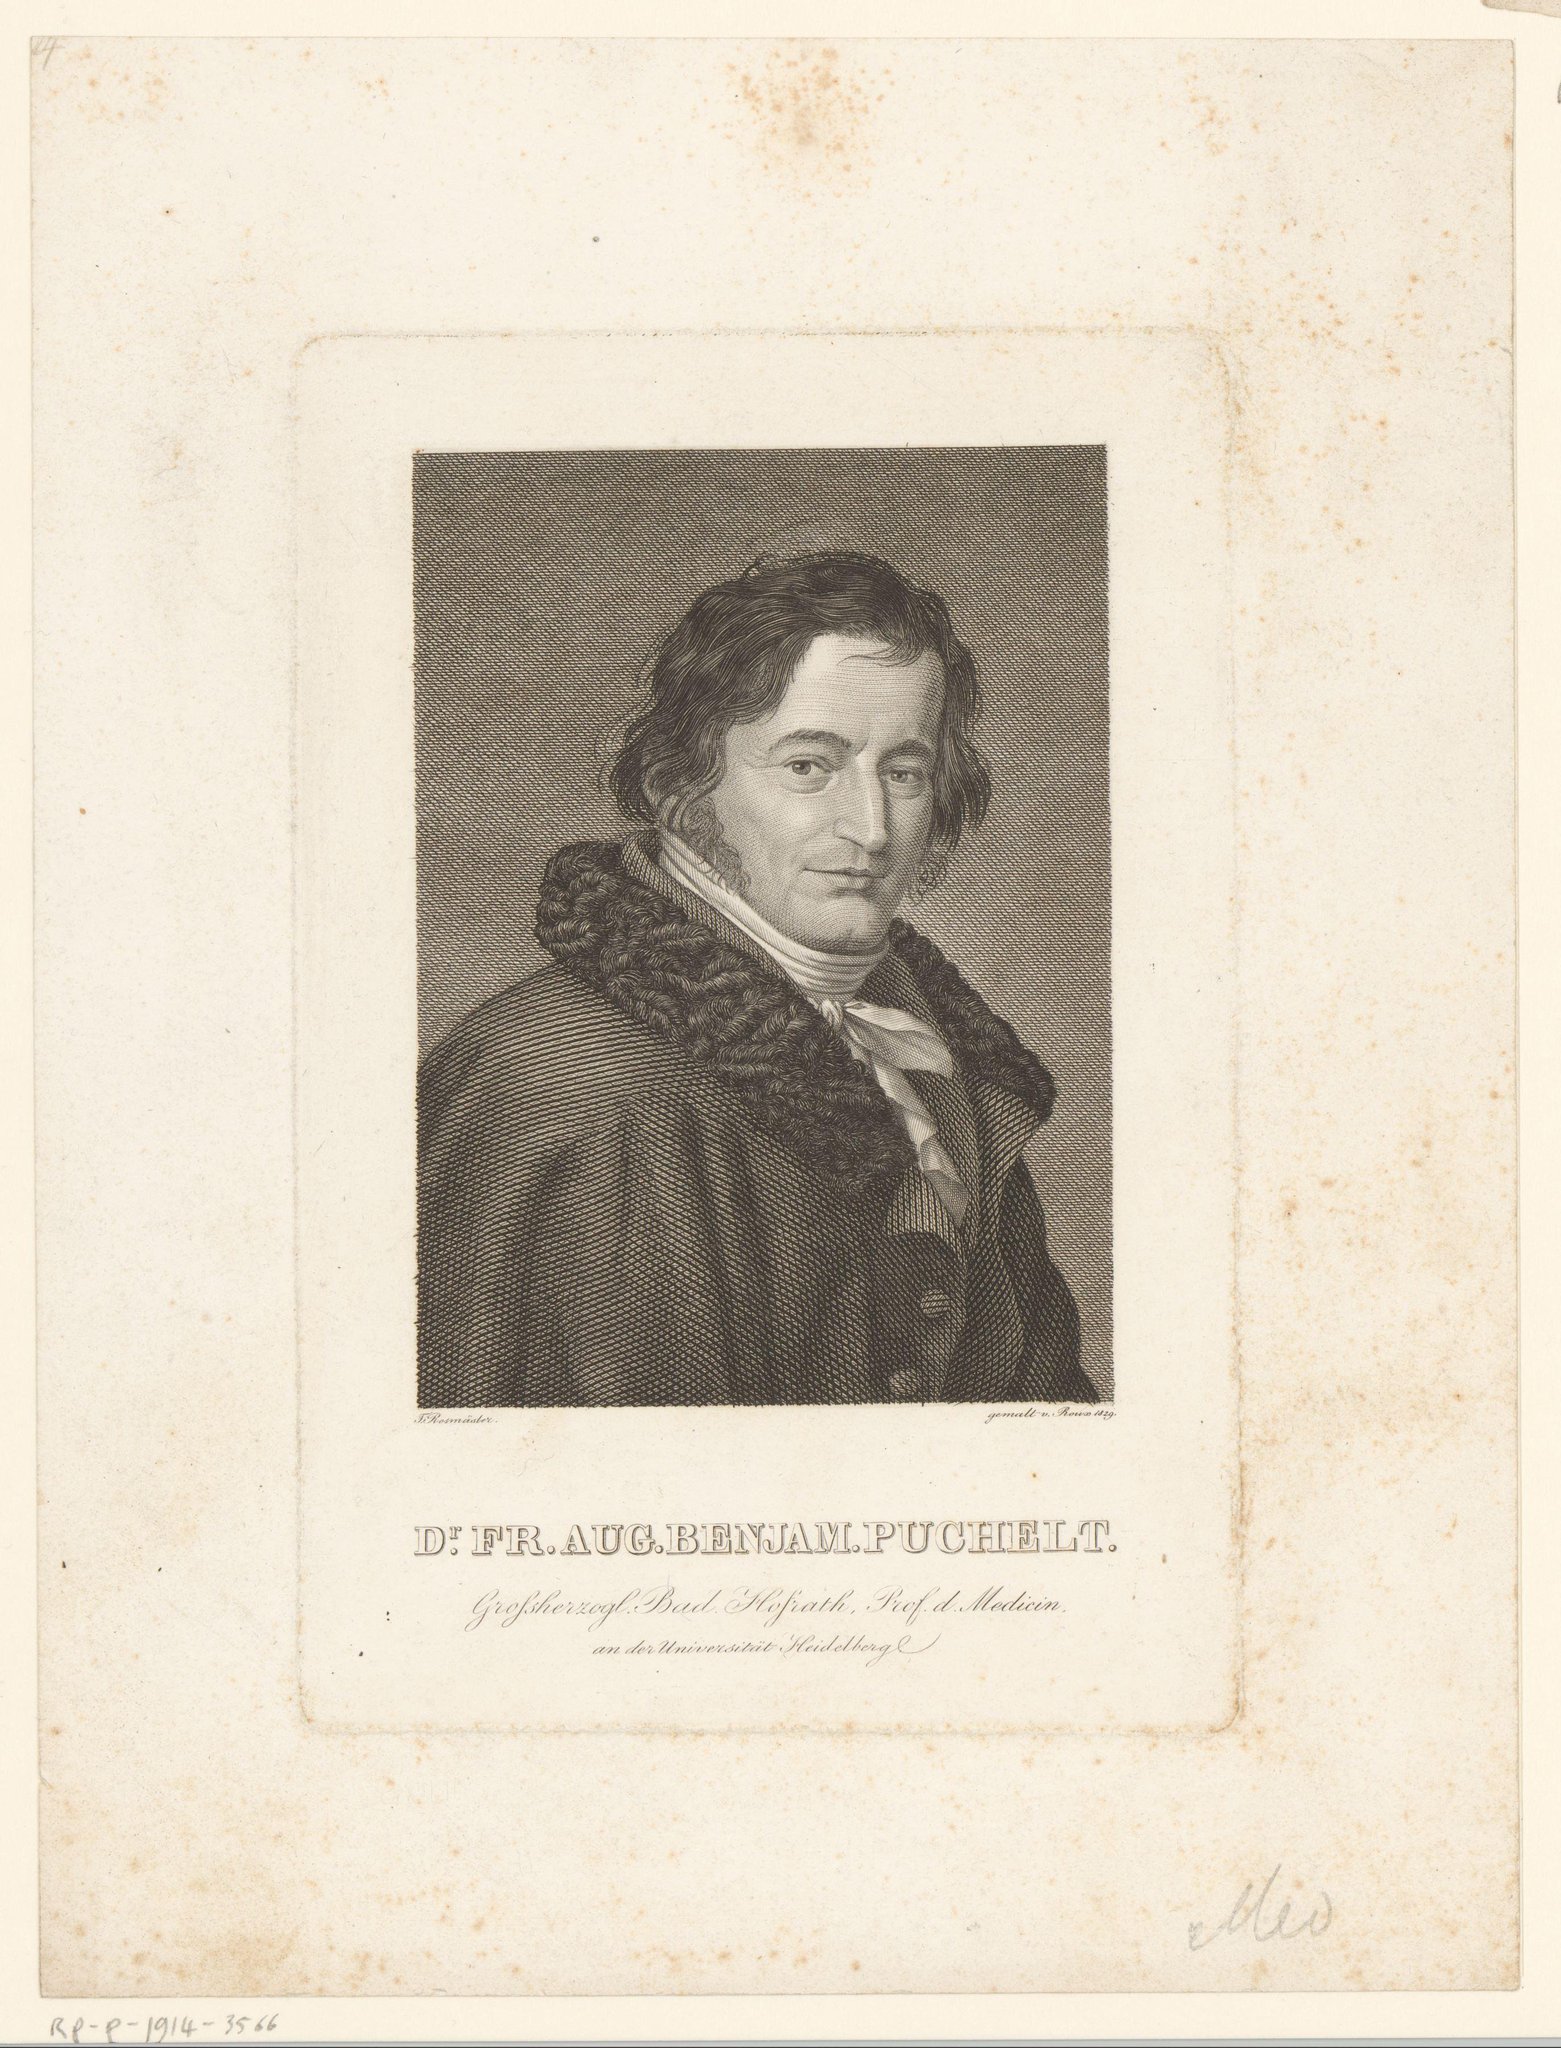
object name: print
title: Portret van Friedrich August Benjamin Puchelt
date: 1829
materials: paper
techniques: engraving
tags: historical persons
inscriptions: collector's mark: Lugt 2228